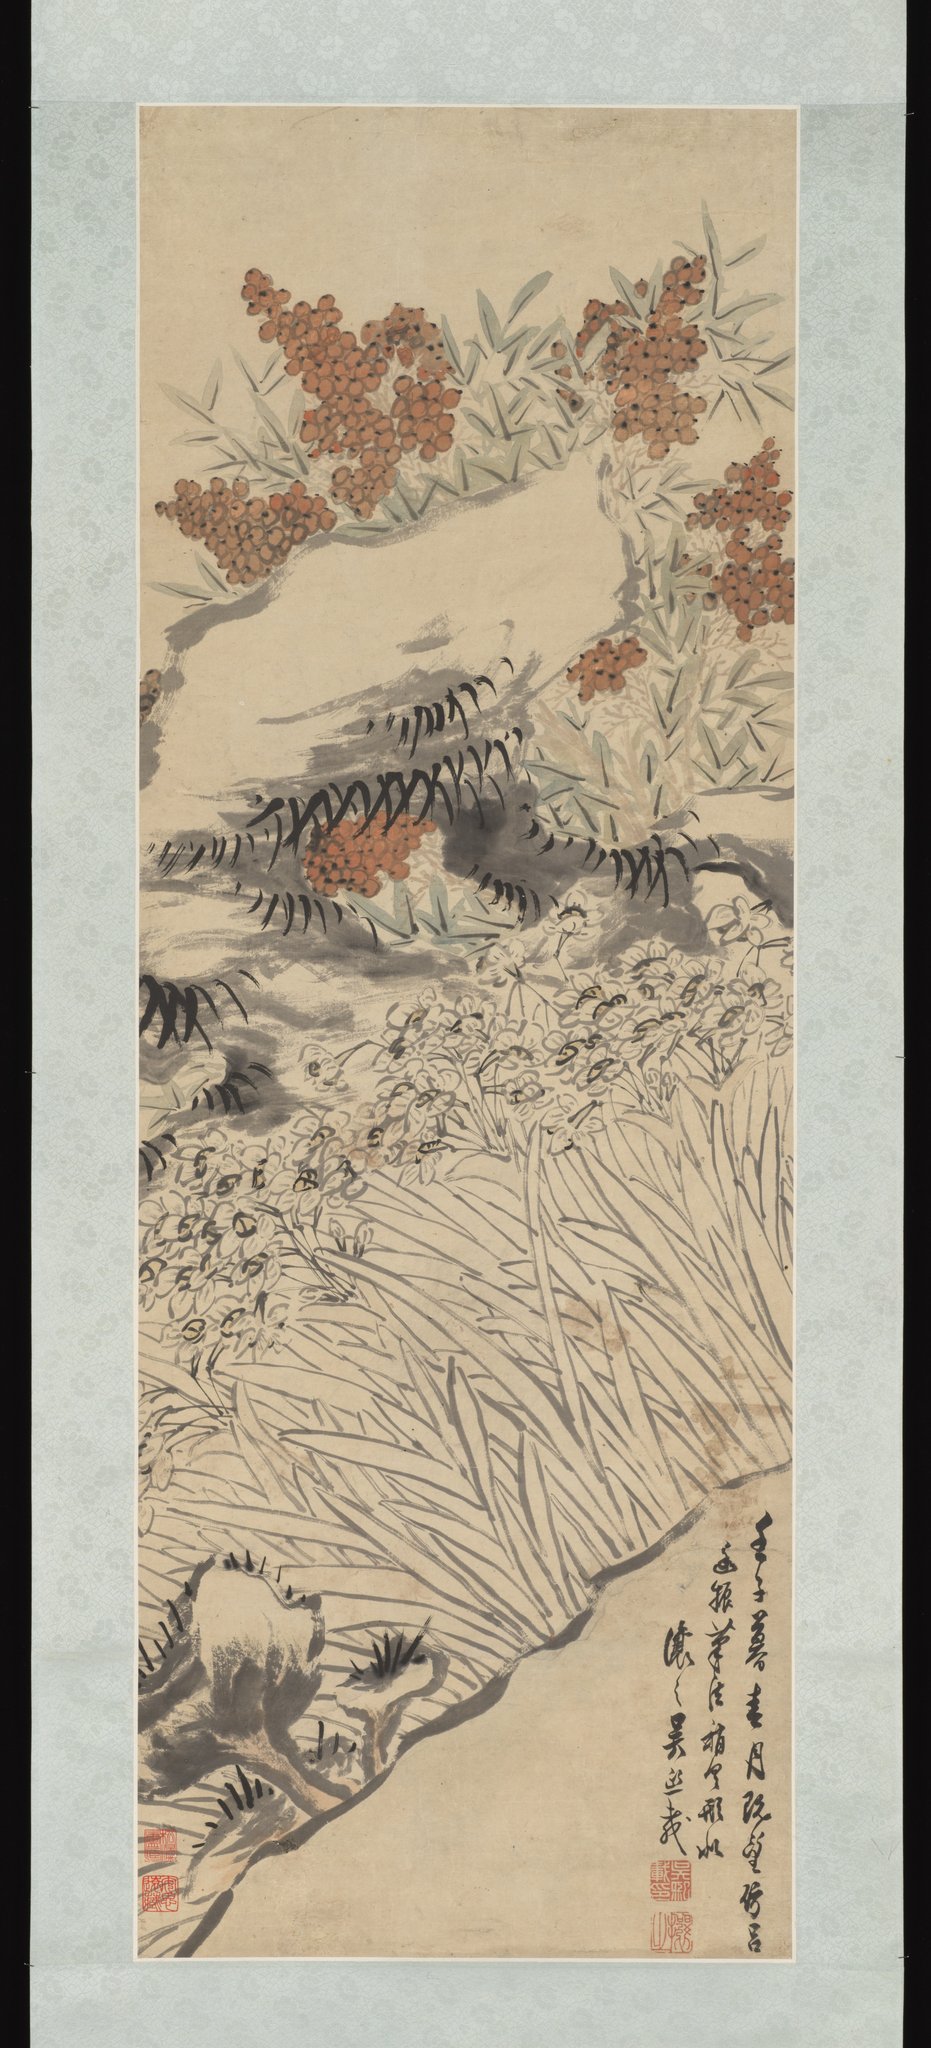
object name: hanging scroll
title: Narcissus, Fungus, and Nandina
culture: chinese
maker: wu xizai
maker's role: artist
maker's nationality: chinese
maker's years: 1799-1870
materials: ink, paper